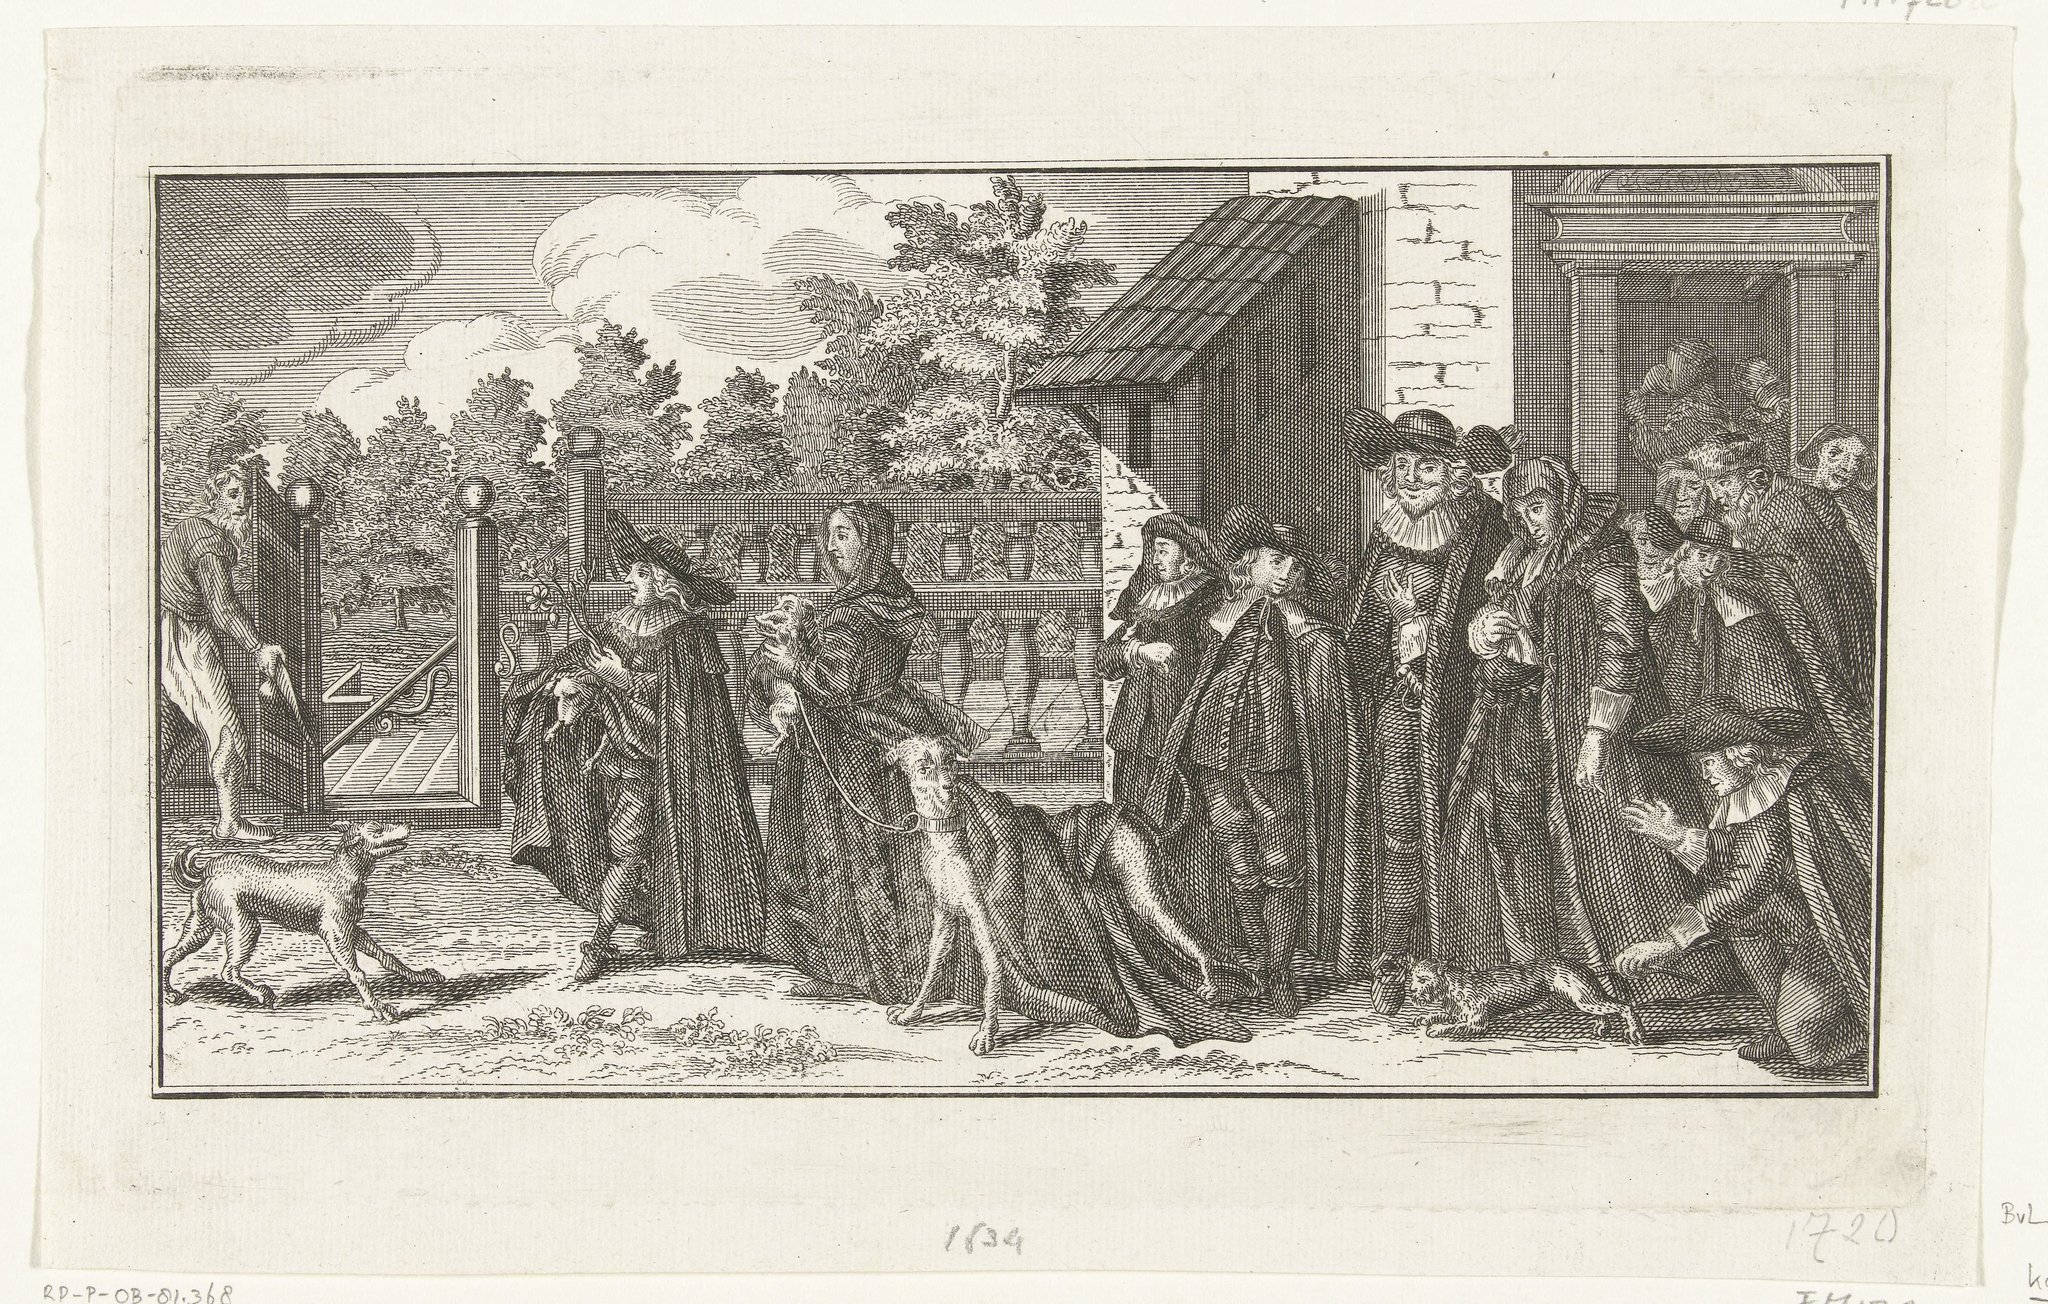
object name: cartoon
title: Begrafenis van de hond van schout Bondt, 1634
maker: Anonymous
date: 1707-1710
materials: paper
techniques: etching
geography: northern netherlands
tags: cortege, funeral procession, dog, leiden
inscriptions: collector's mark: Lugt 240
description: Kopie naar de prent gebruikt als illustratie in: Joost van den Vondel, Hekeldichten, P. Brakman, Amersfoort 1707. Misschien komt deze prent overeen met de prent in de collectie A.J. Nijland, beschreven door Muller onder nummer FMH 1720b (Suppl.).